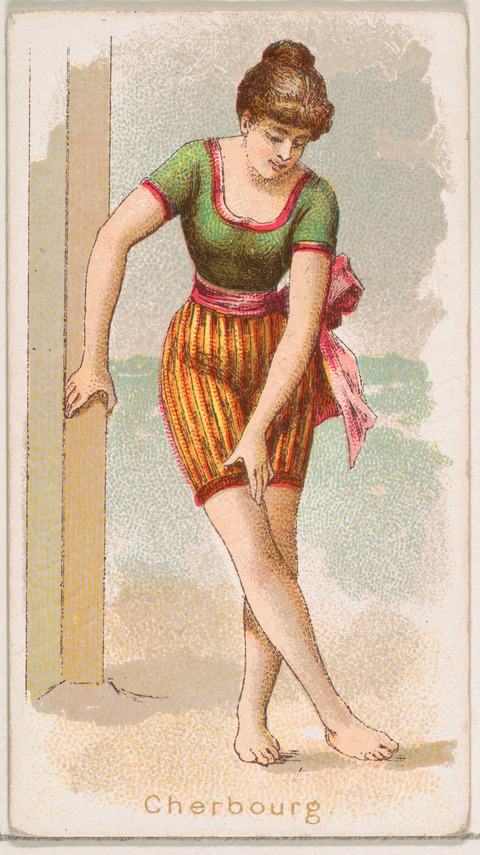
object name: print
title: Cherbourg, from the Fancy Bathers series (N187) issued by Wm. S. Kimball & Co.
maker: william s. kimball & company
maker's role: publisher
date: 1889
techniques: color lithograph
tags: women